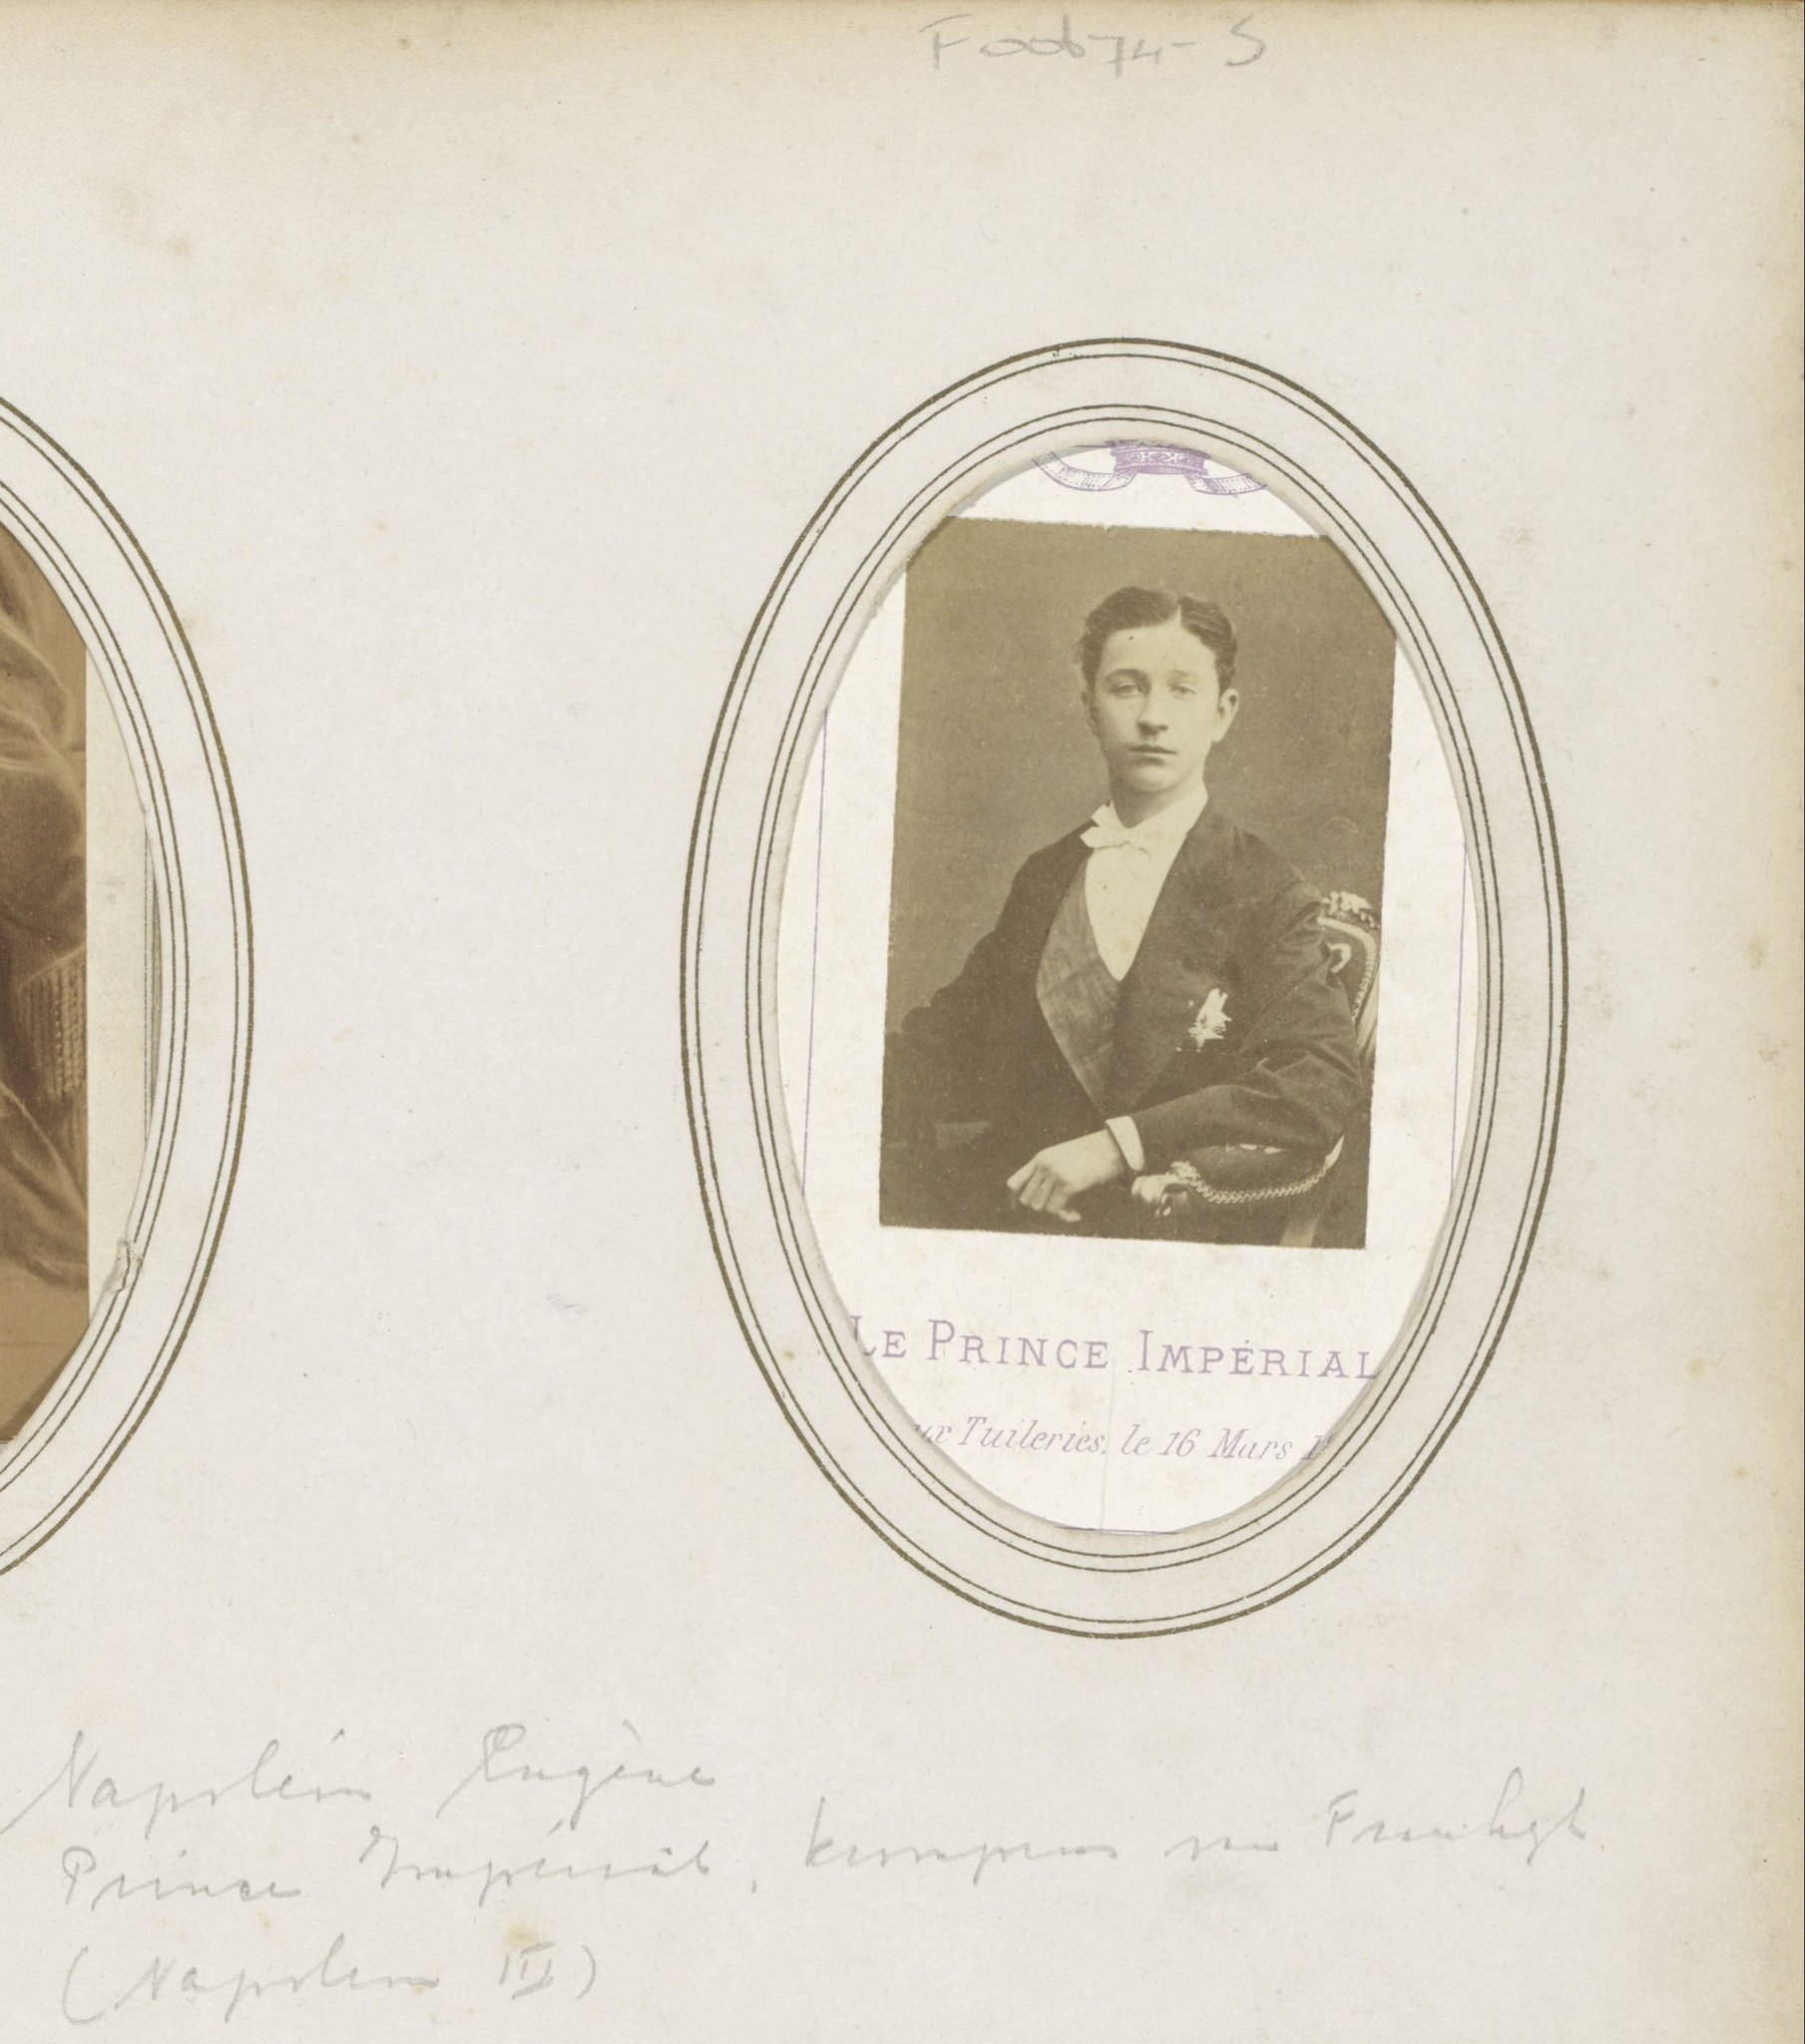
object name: carte de visite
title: Portret van Napoleon Eugène, kroonprins van Frankrijk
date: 1865-1880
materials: cardboard, paper, photographic support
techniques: albumen print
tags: paris, armchair, seat, historical persons, neck-gear ~ clothing, clothing for the upper part of the body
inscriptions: address: ‘156 Rue de Rivoli’, name: ‘Le Prince Impérial Né aux Tuileries la 16 Mars 1856.’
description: Onderdeel van Fotoalbum met 123 cartes-de-visite van leden van Europese vorstenhuizen, politici en bekende personen.